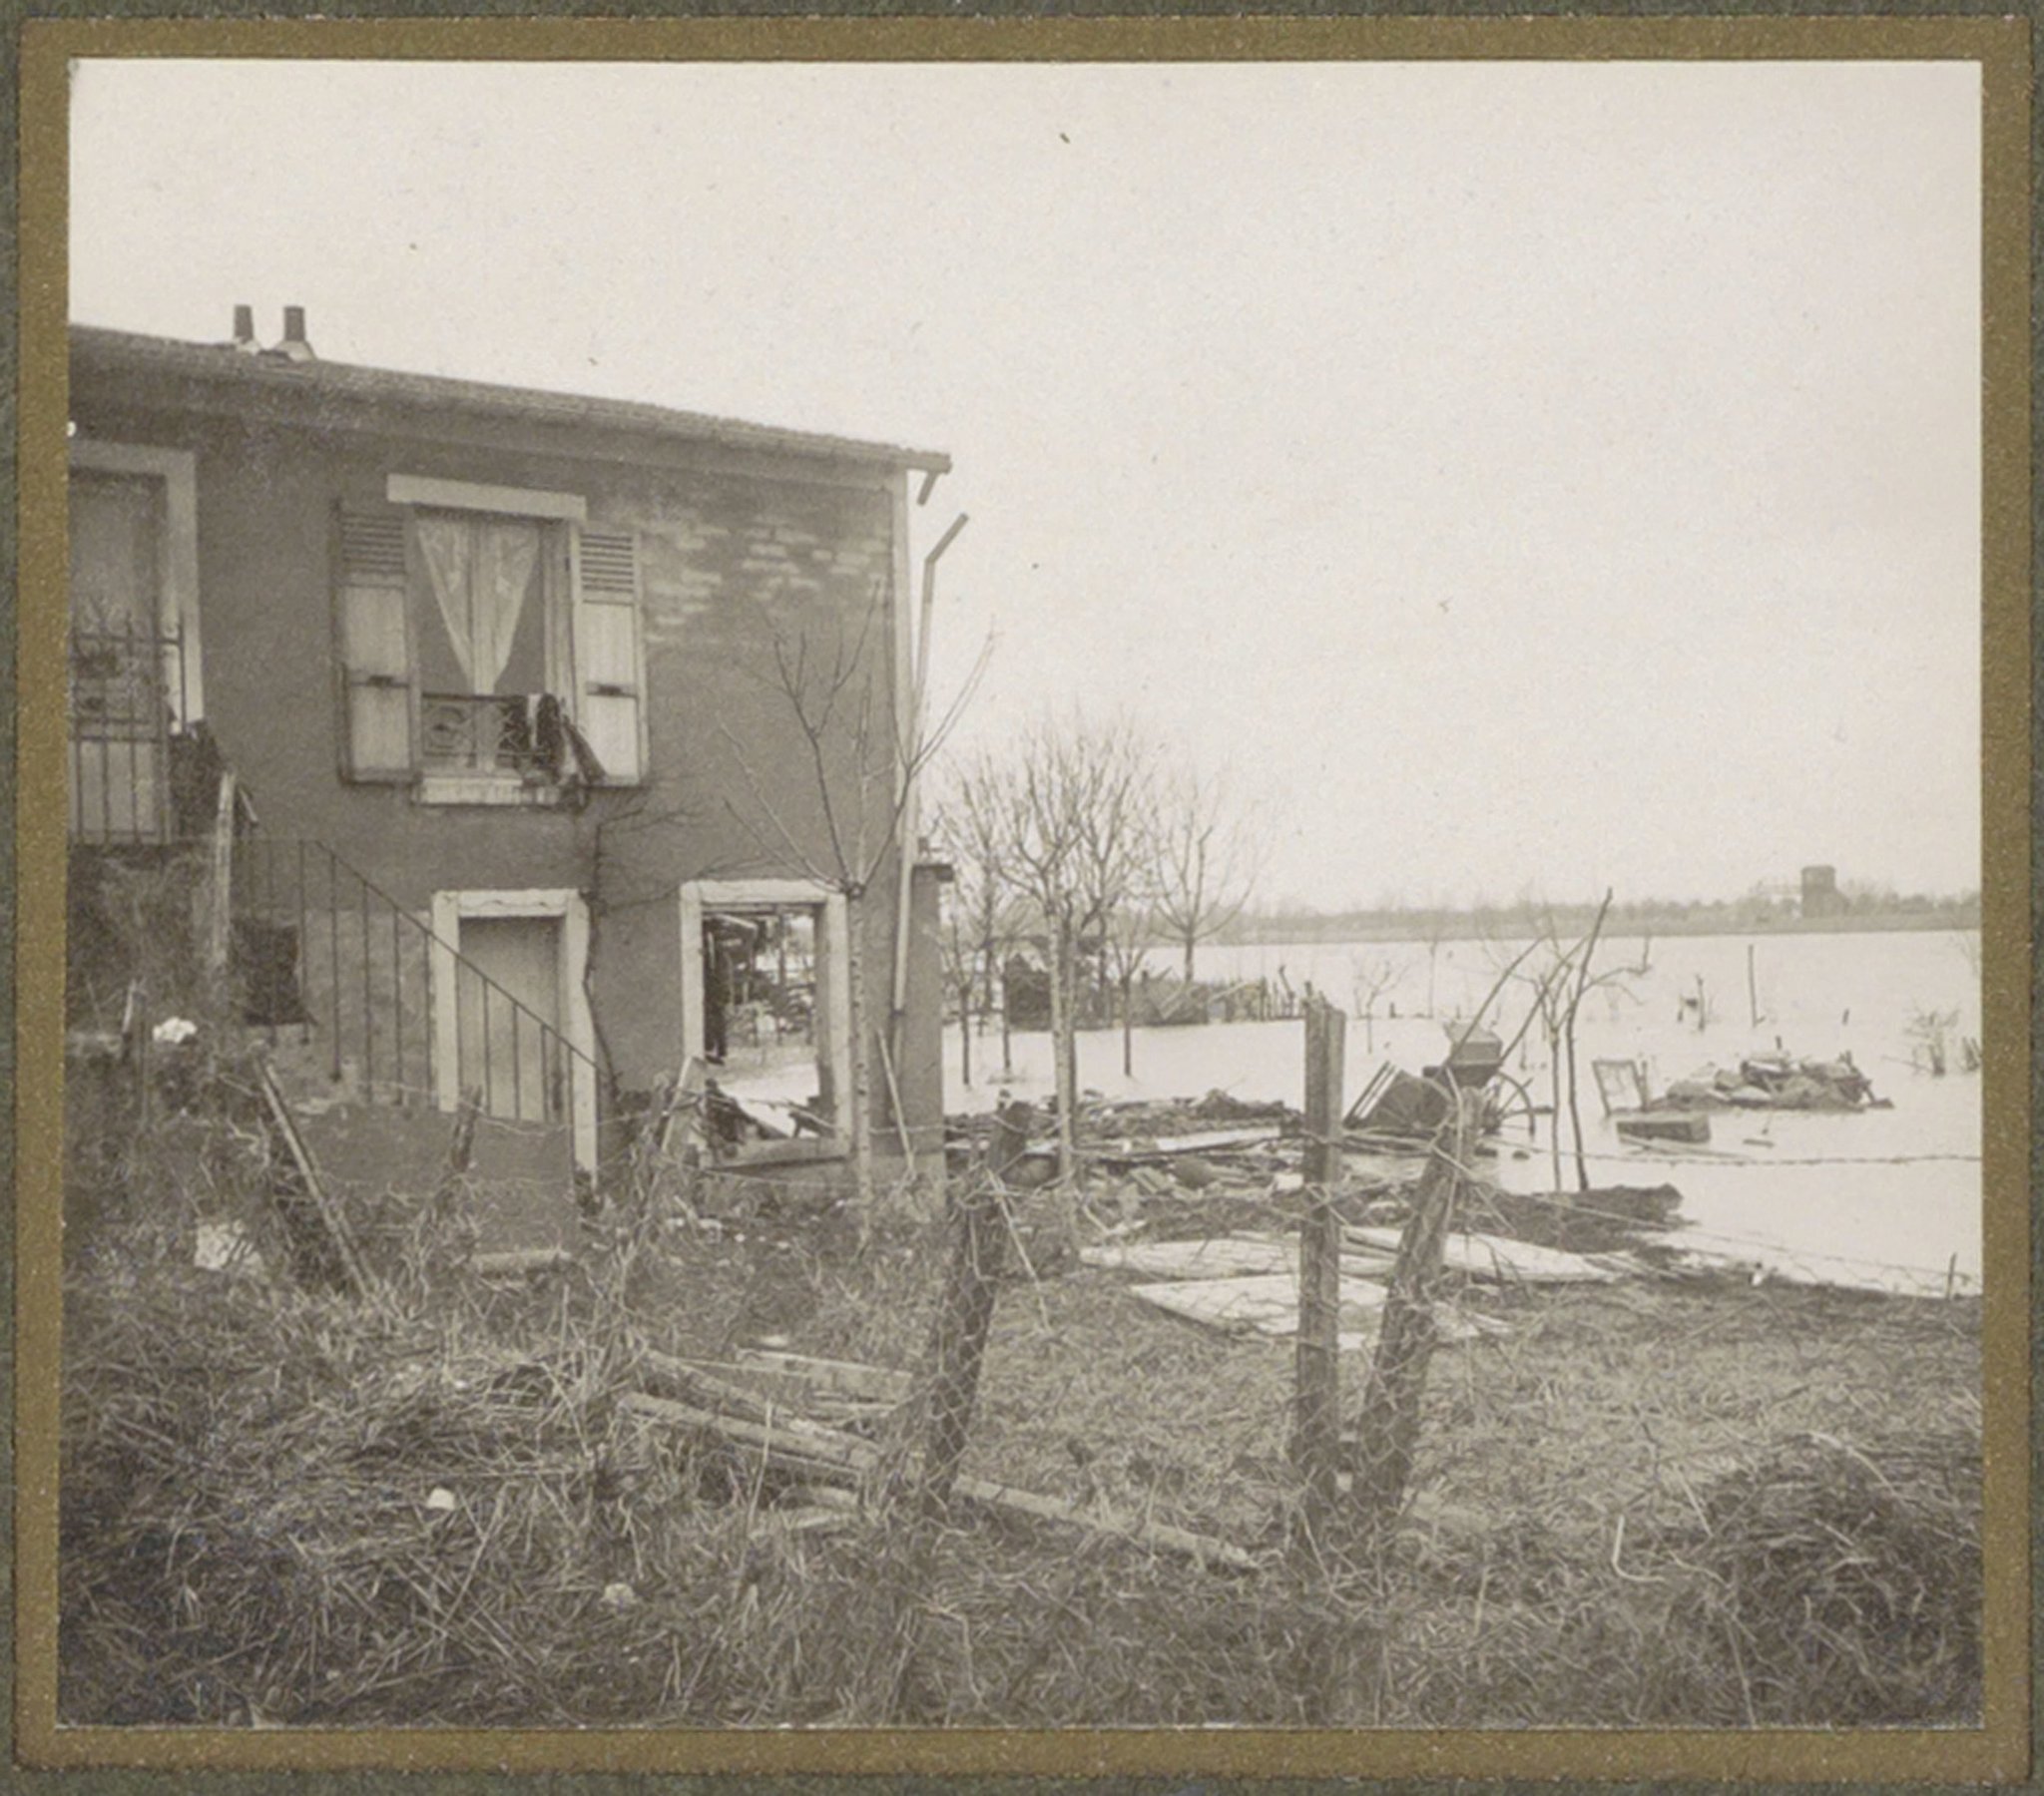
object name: photograph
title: Verwoest huis in een ondergelopen buitenwijk van Parijs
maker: g. dangereux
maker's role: fotograaf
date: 1901-1910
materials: photographic support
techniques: matte daylight collodion silver print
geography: paris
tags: flood (+ landscape with figures, staffage), paris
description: Onderdeel van fotoalbum overstroming Parijs en voorsteden 1910.